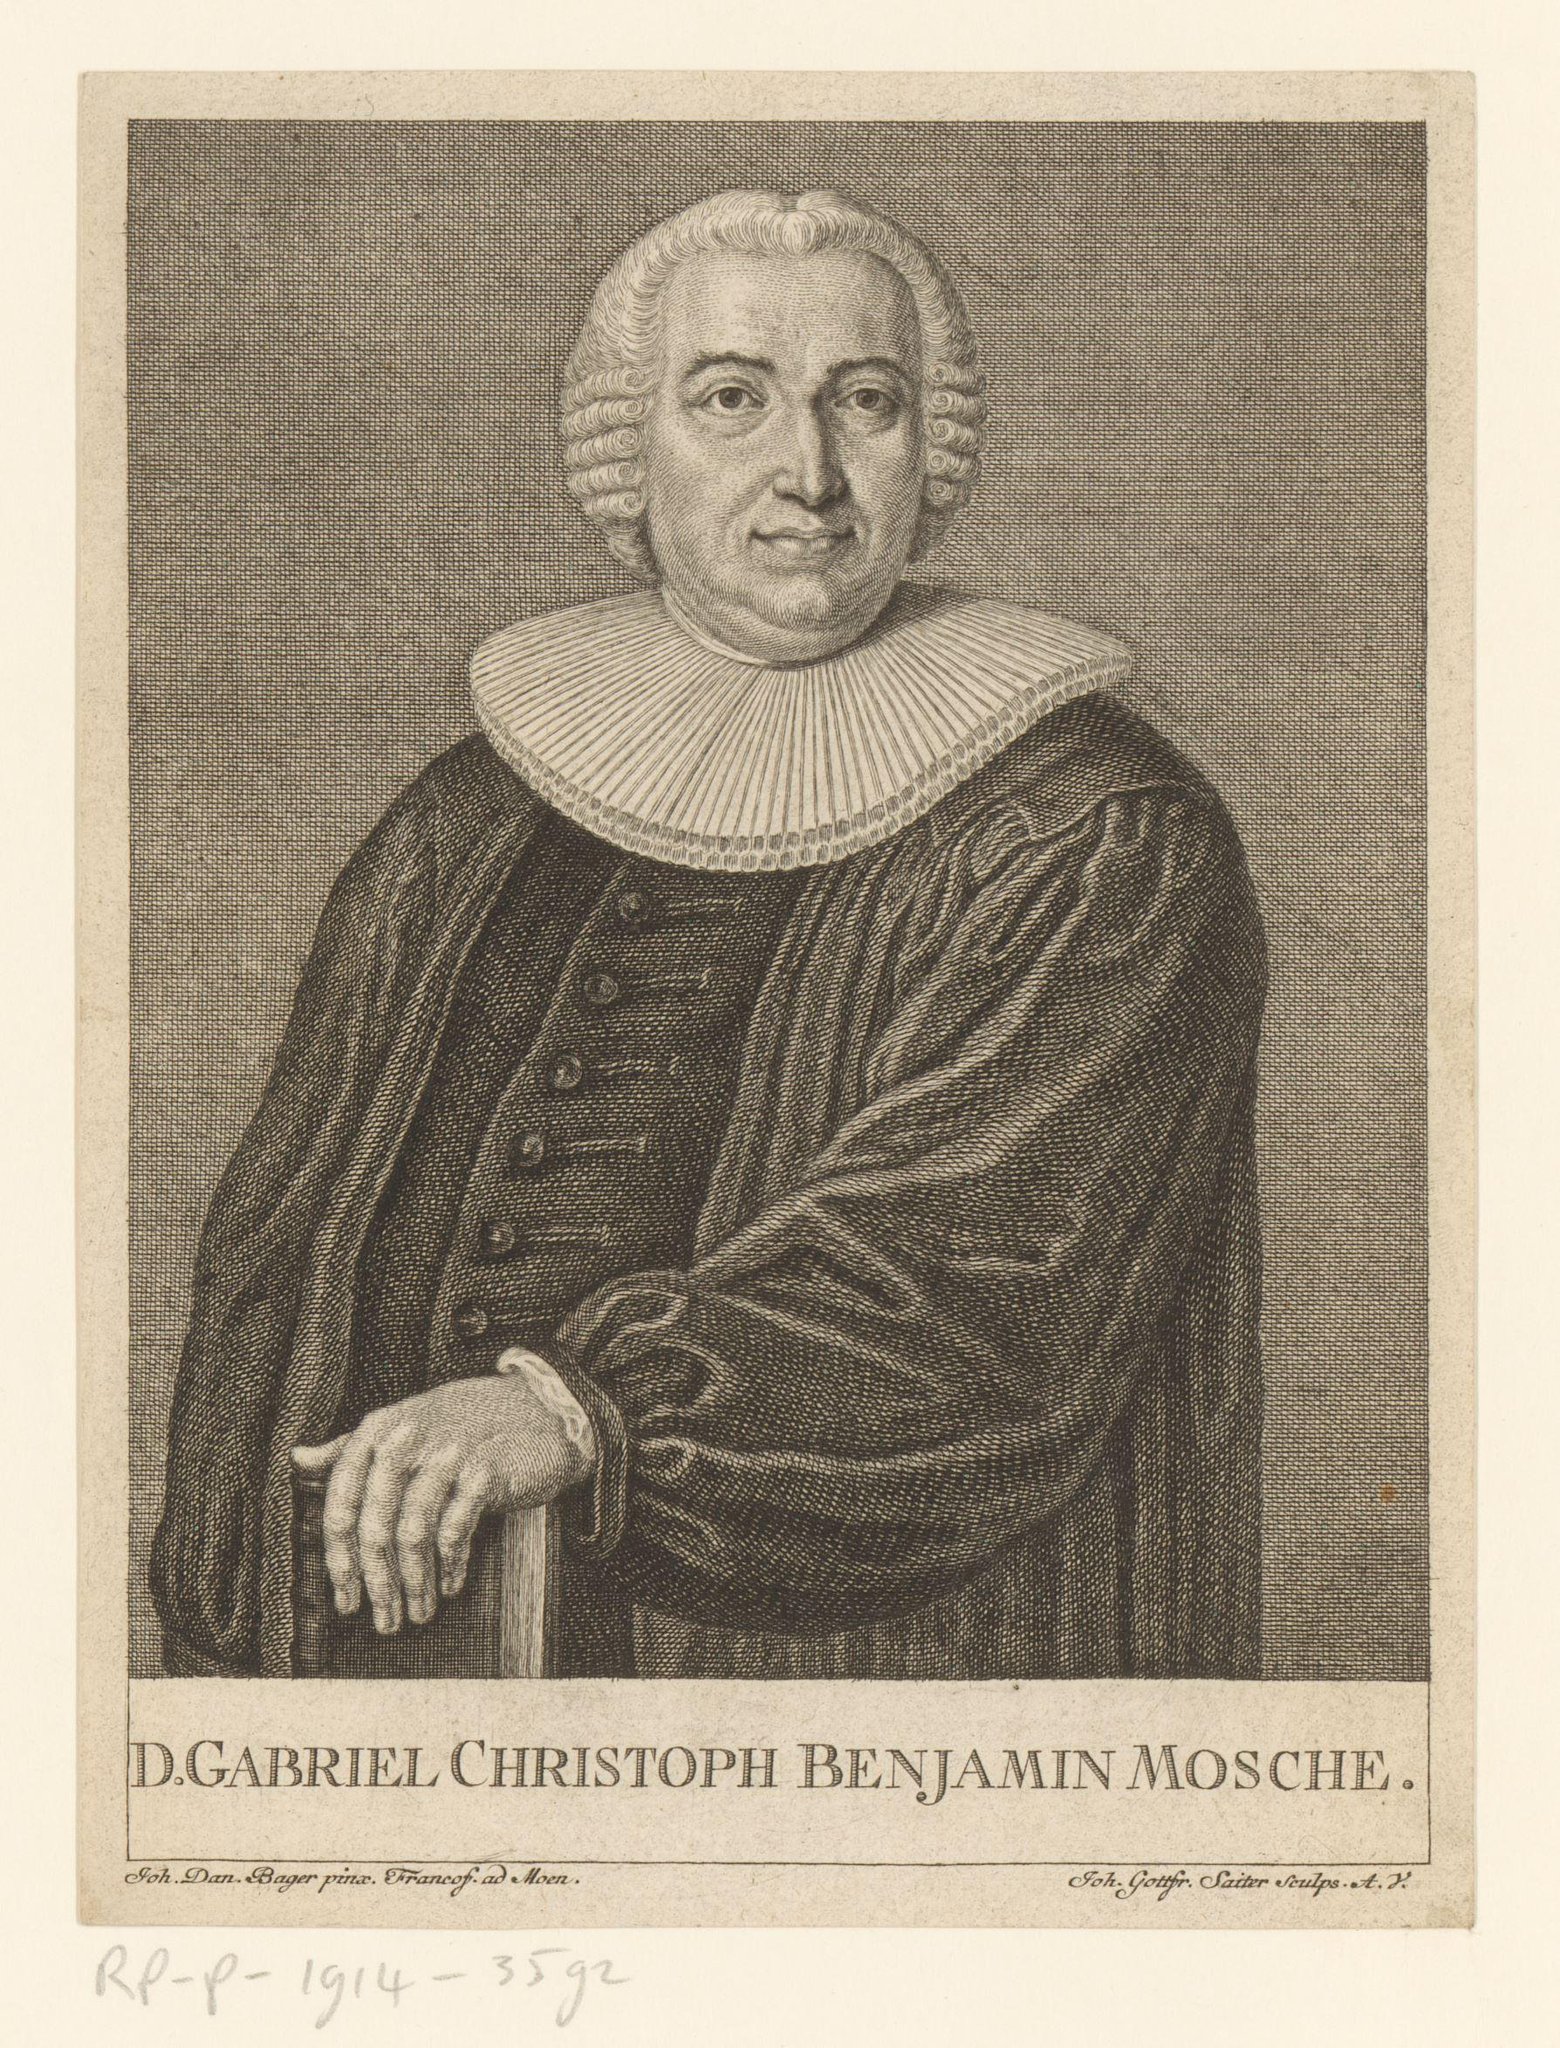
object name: print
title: Portret van Gabriel Christoph Benjamin Mosche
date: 1727-1800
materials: paper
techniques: engraving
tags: historical persons, book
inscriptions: collector's mark: Lugt 2228